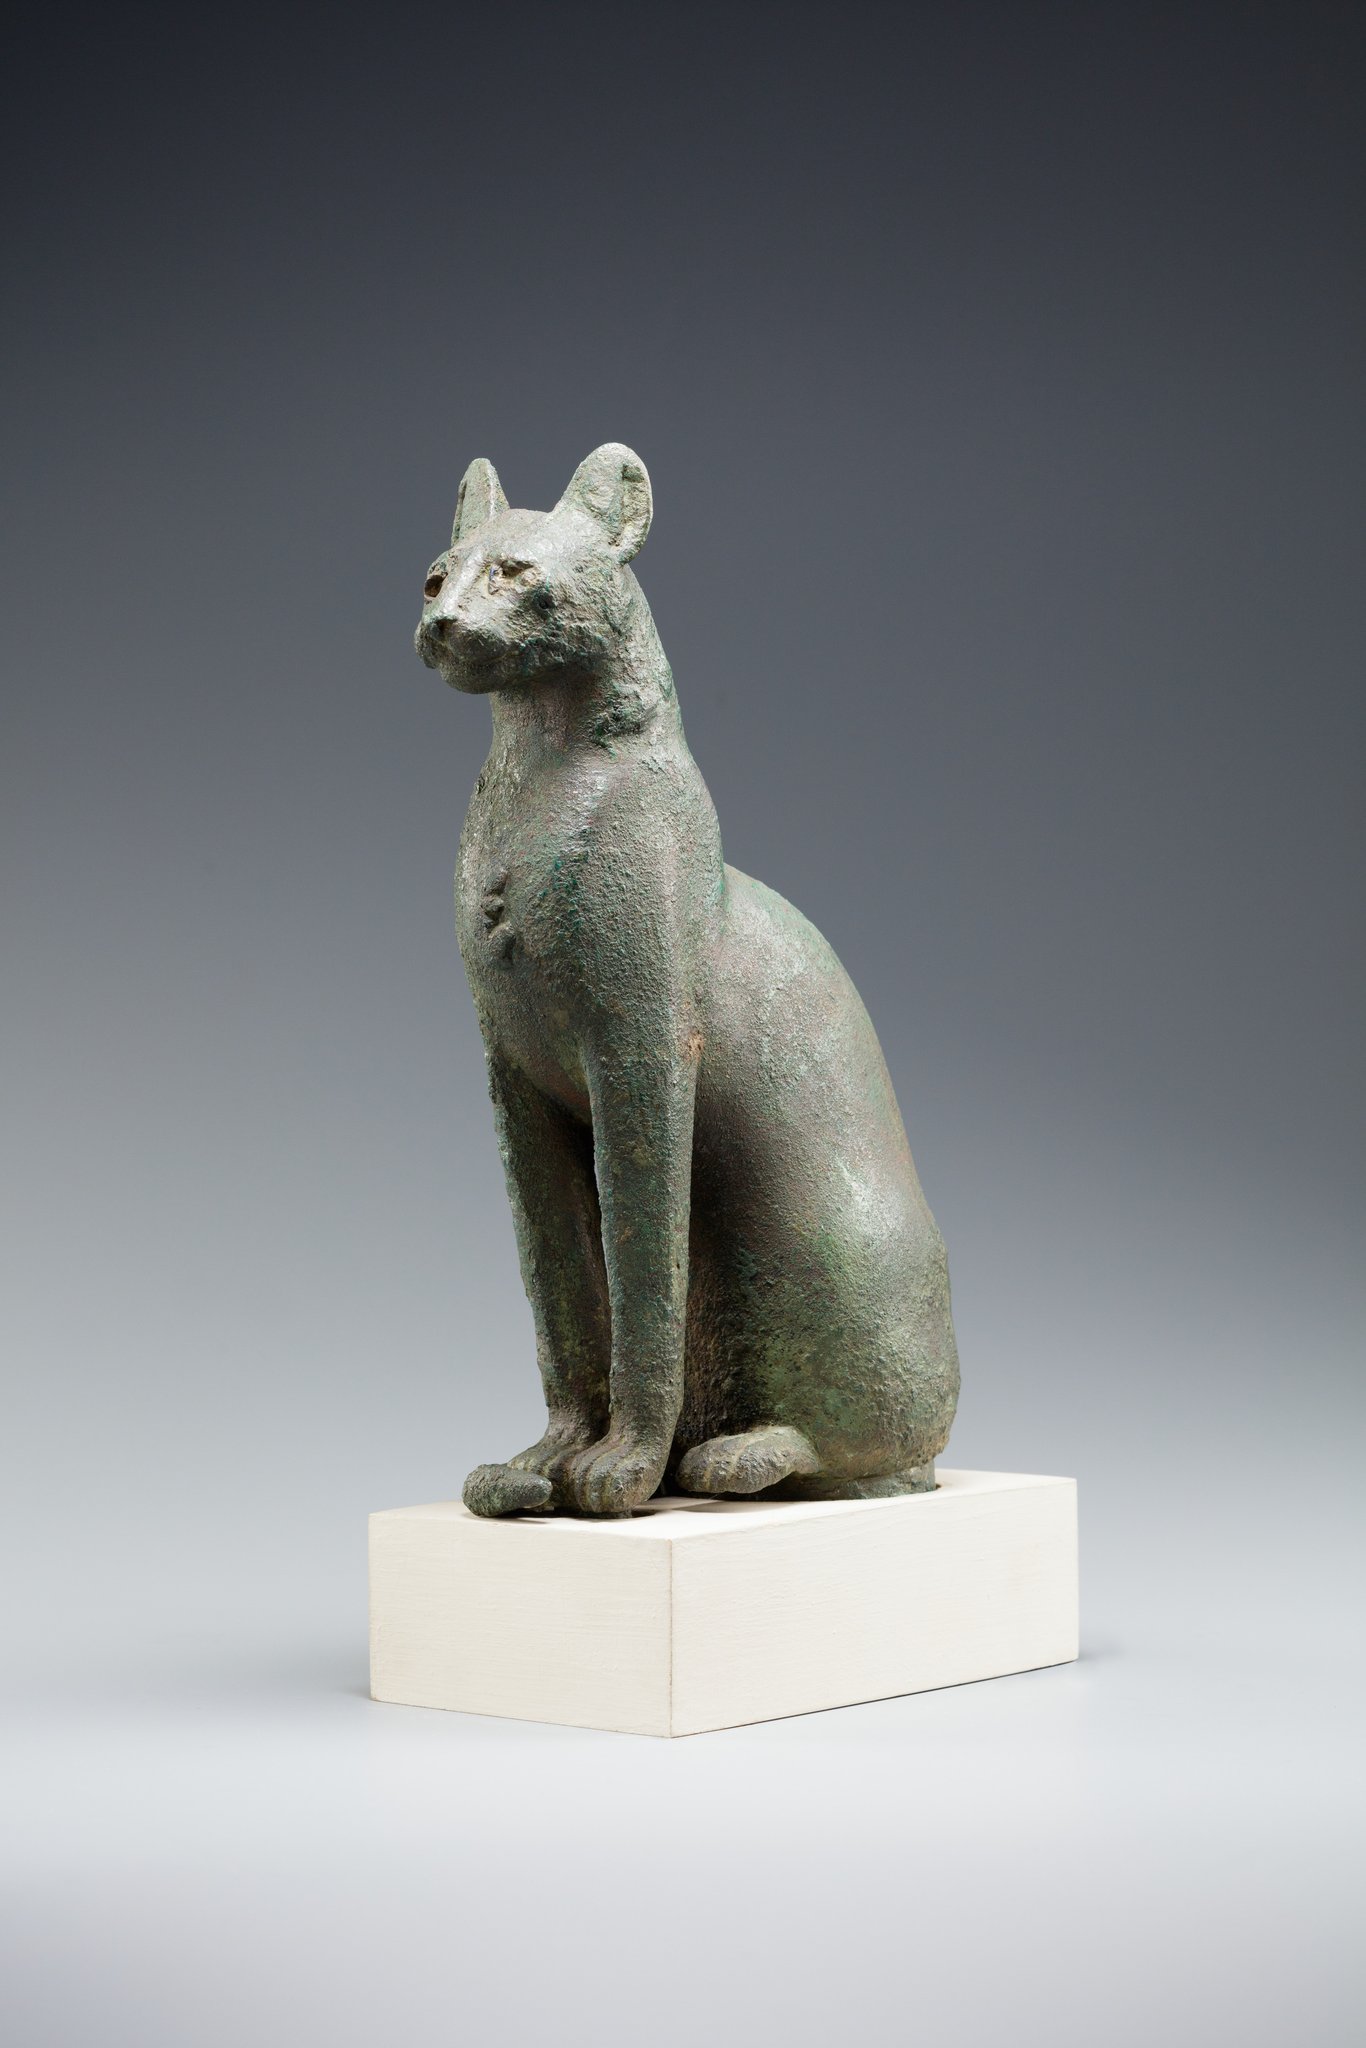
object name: figurine, cat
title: Cat with image of Bastet on breast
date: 664-630 BCE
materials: metal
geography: egypt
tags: cats